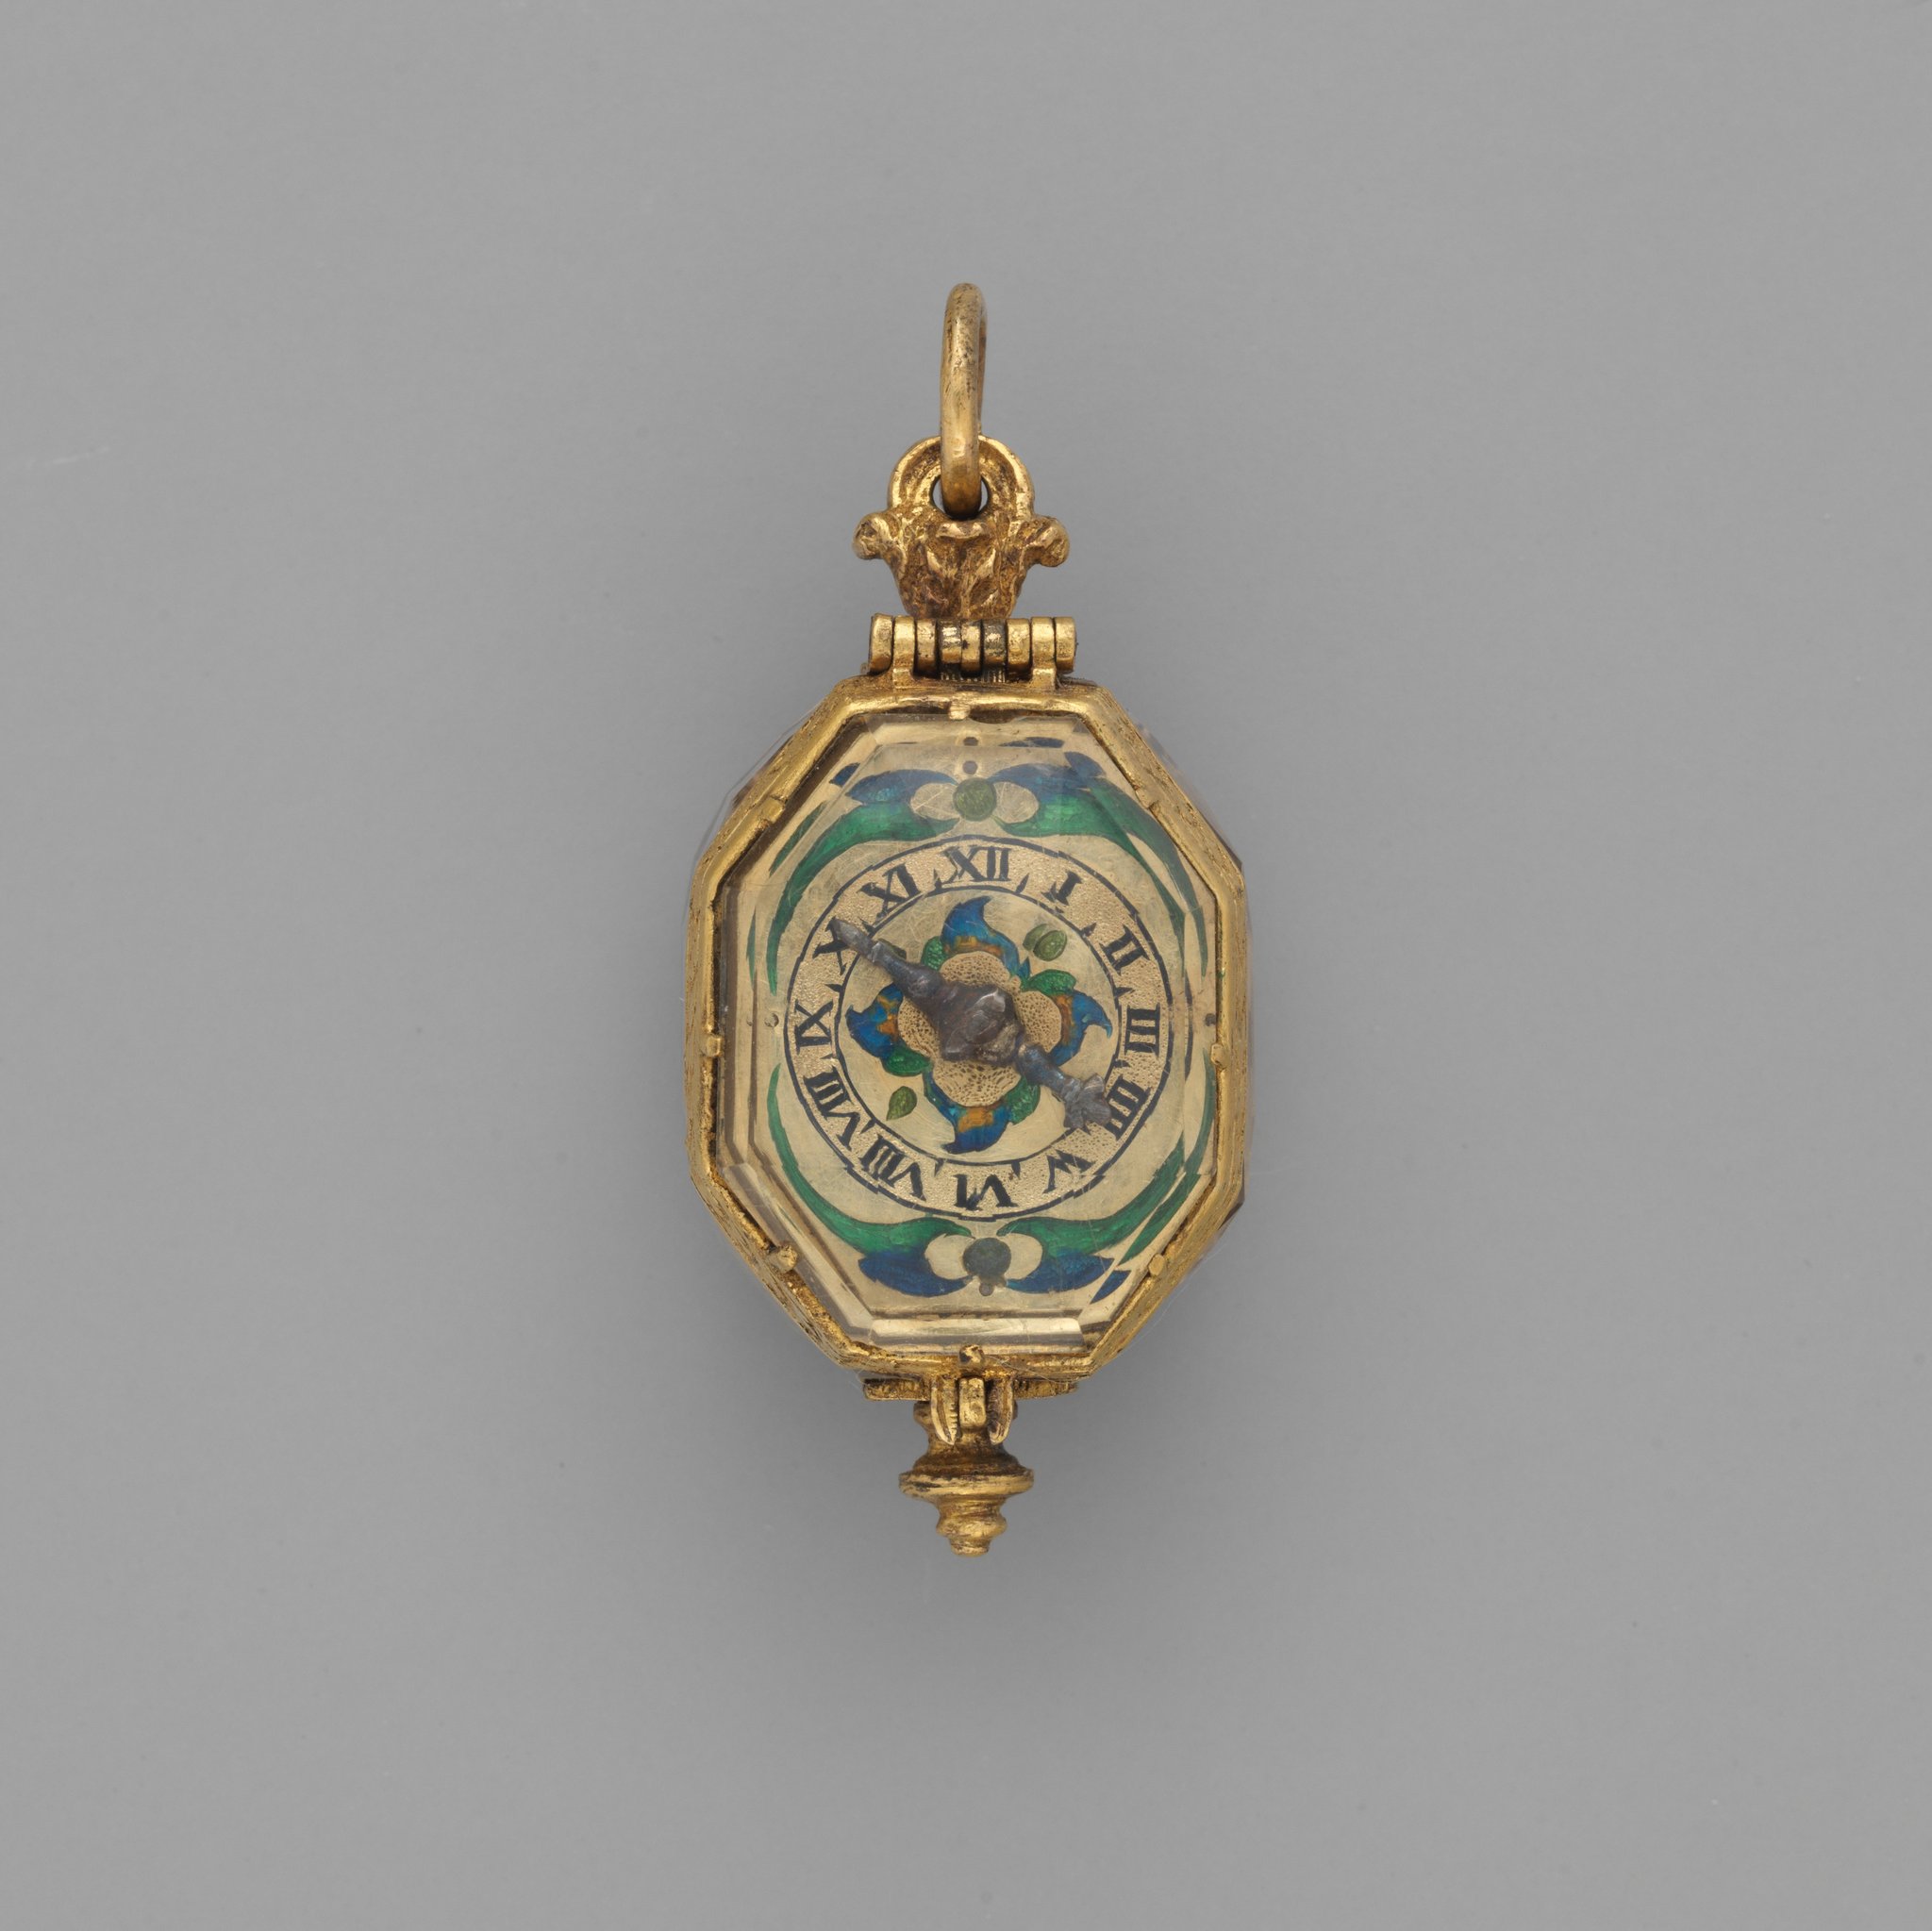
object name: watch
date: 1620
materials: crystal, enamel, gilt, metal